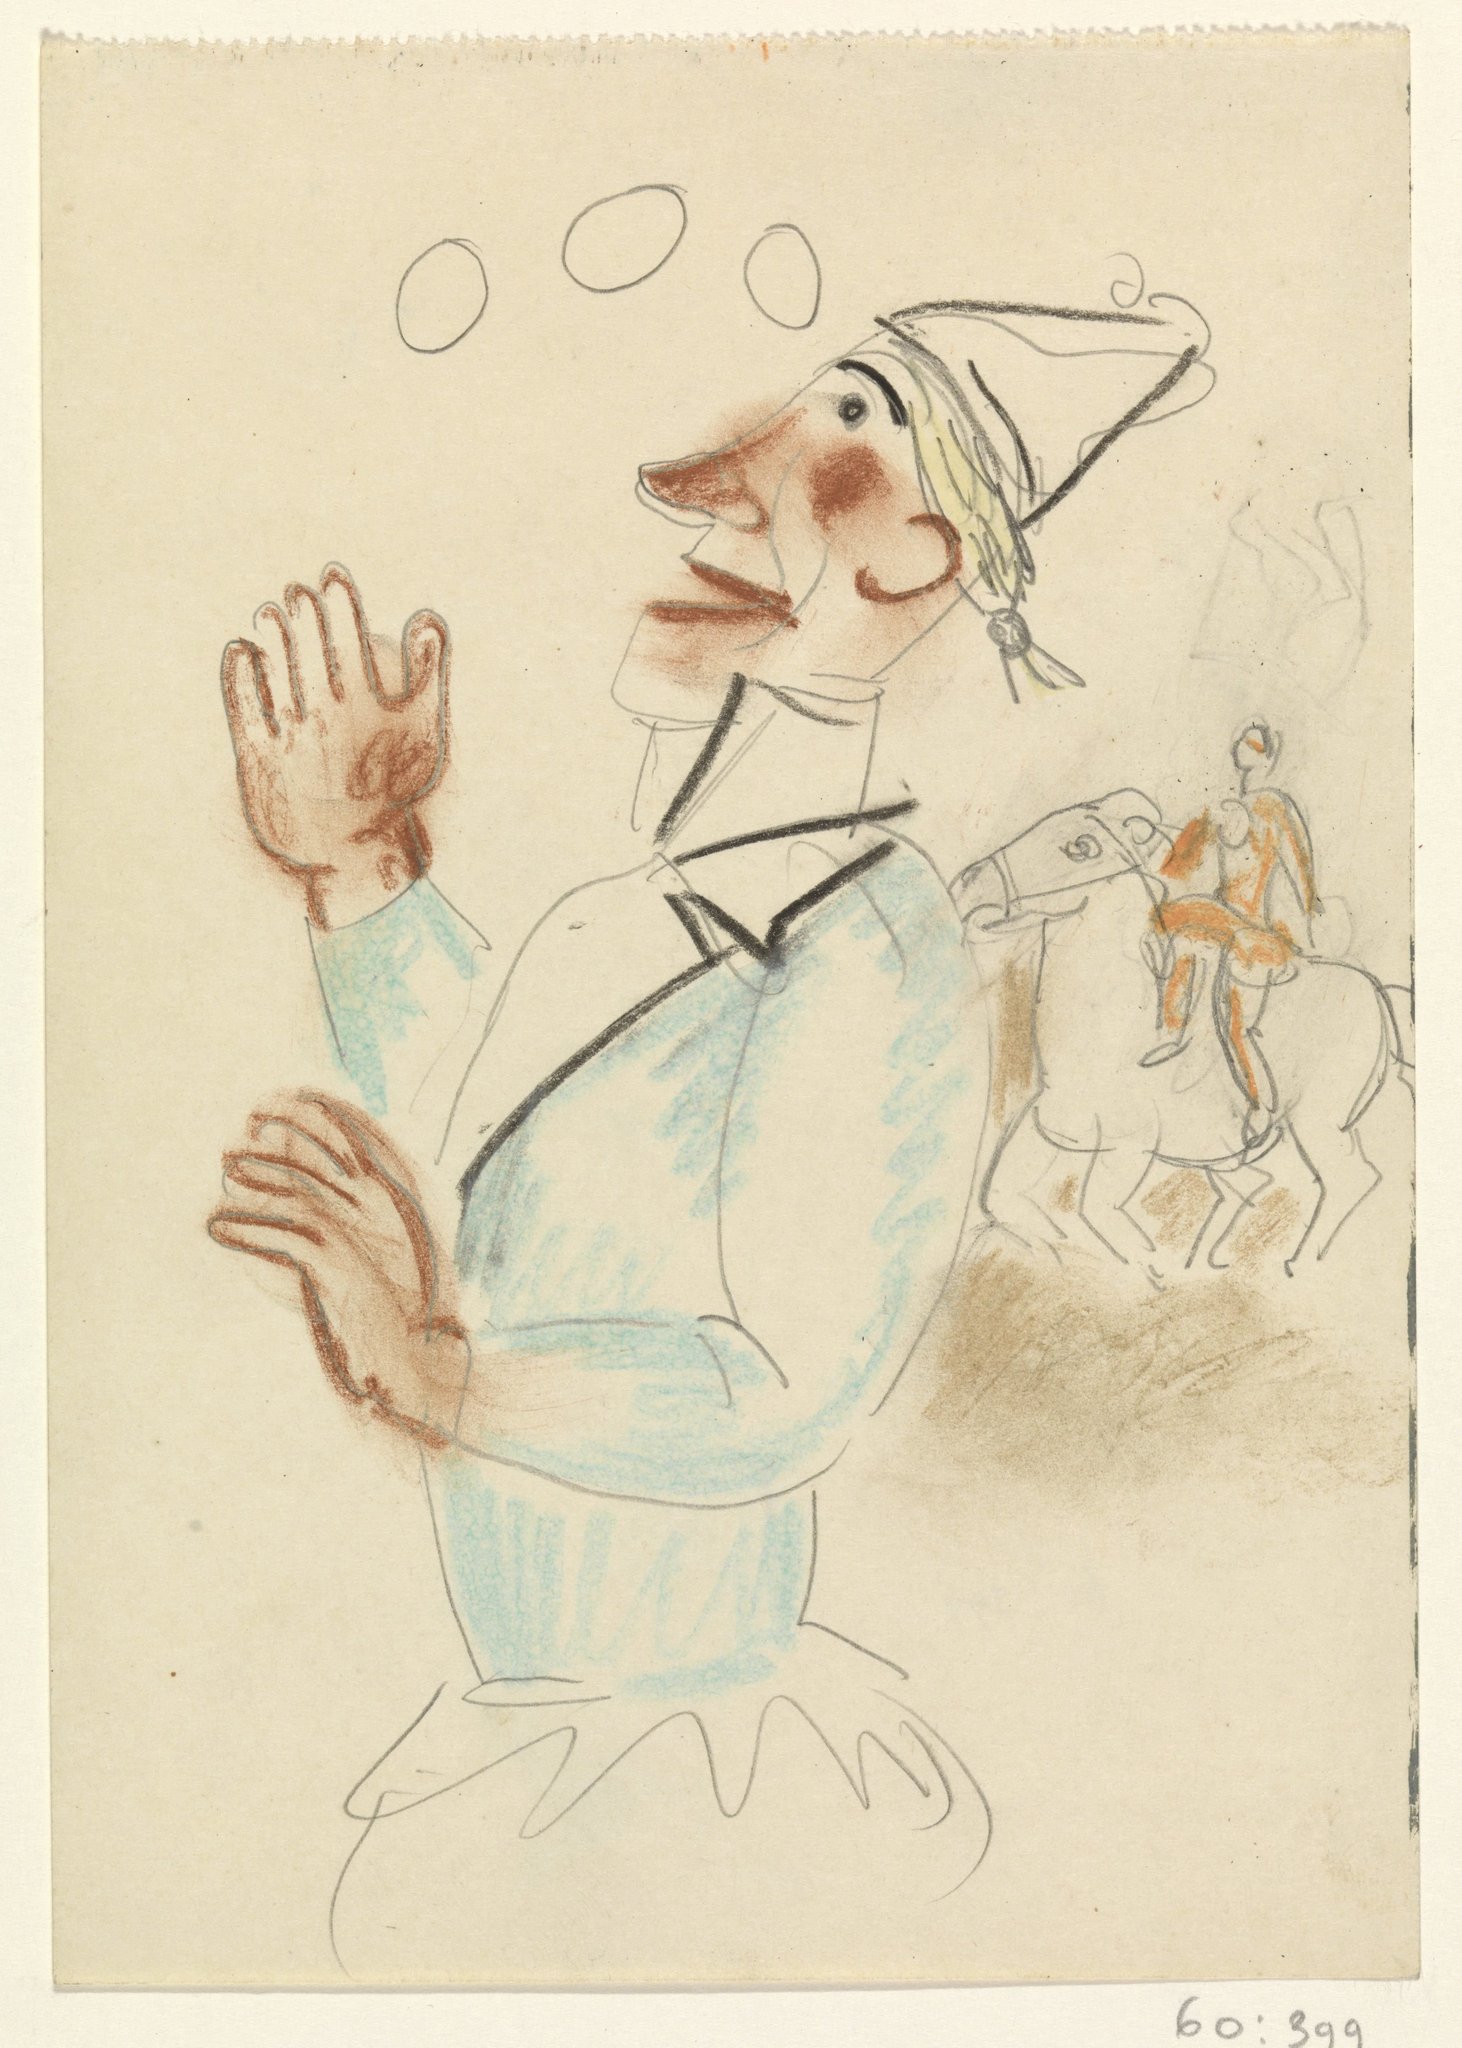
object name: drawing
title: Clown en ruiter te paard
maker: leo gestel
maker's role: draughtsman, print maker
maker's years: 1881-1941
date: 1891-1941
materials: chalk, paper, pencil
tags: riding a horse, ass, or mule; rider, horseman, clown, horse